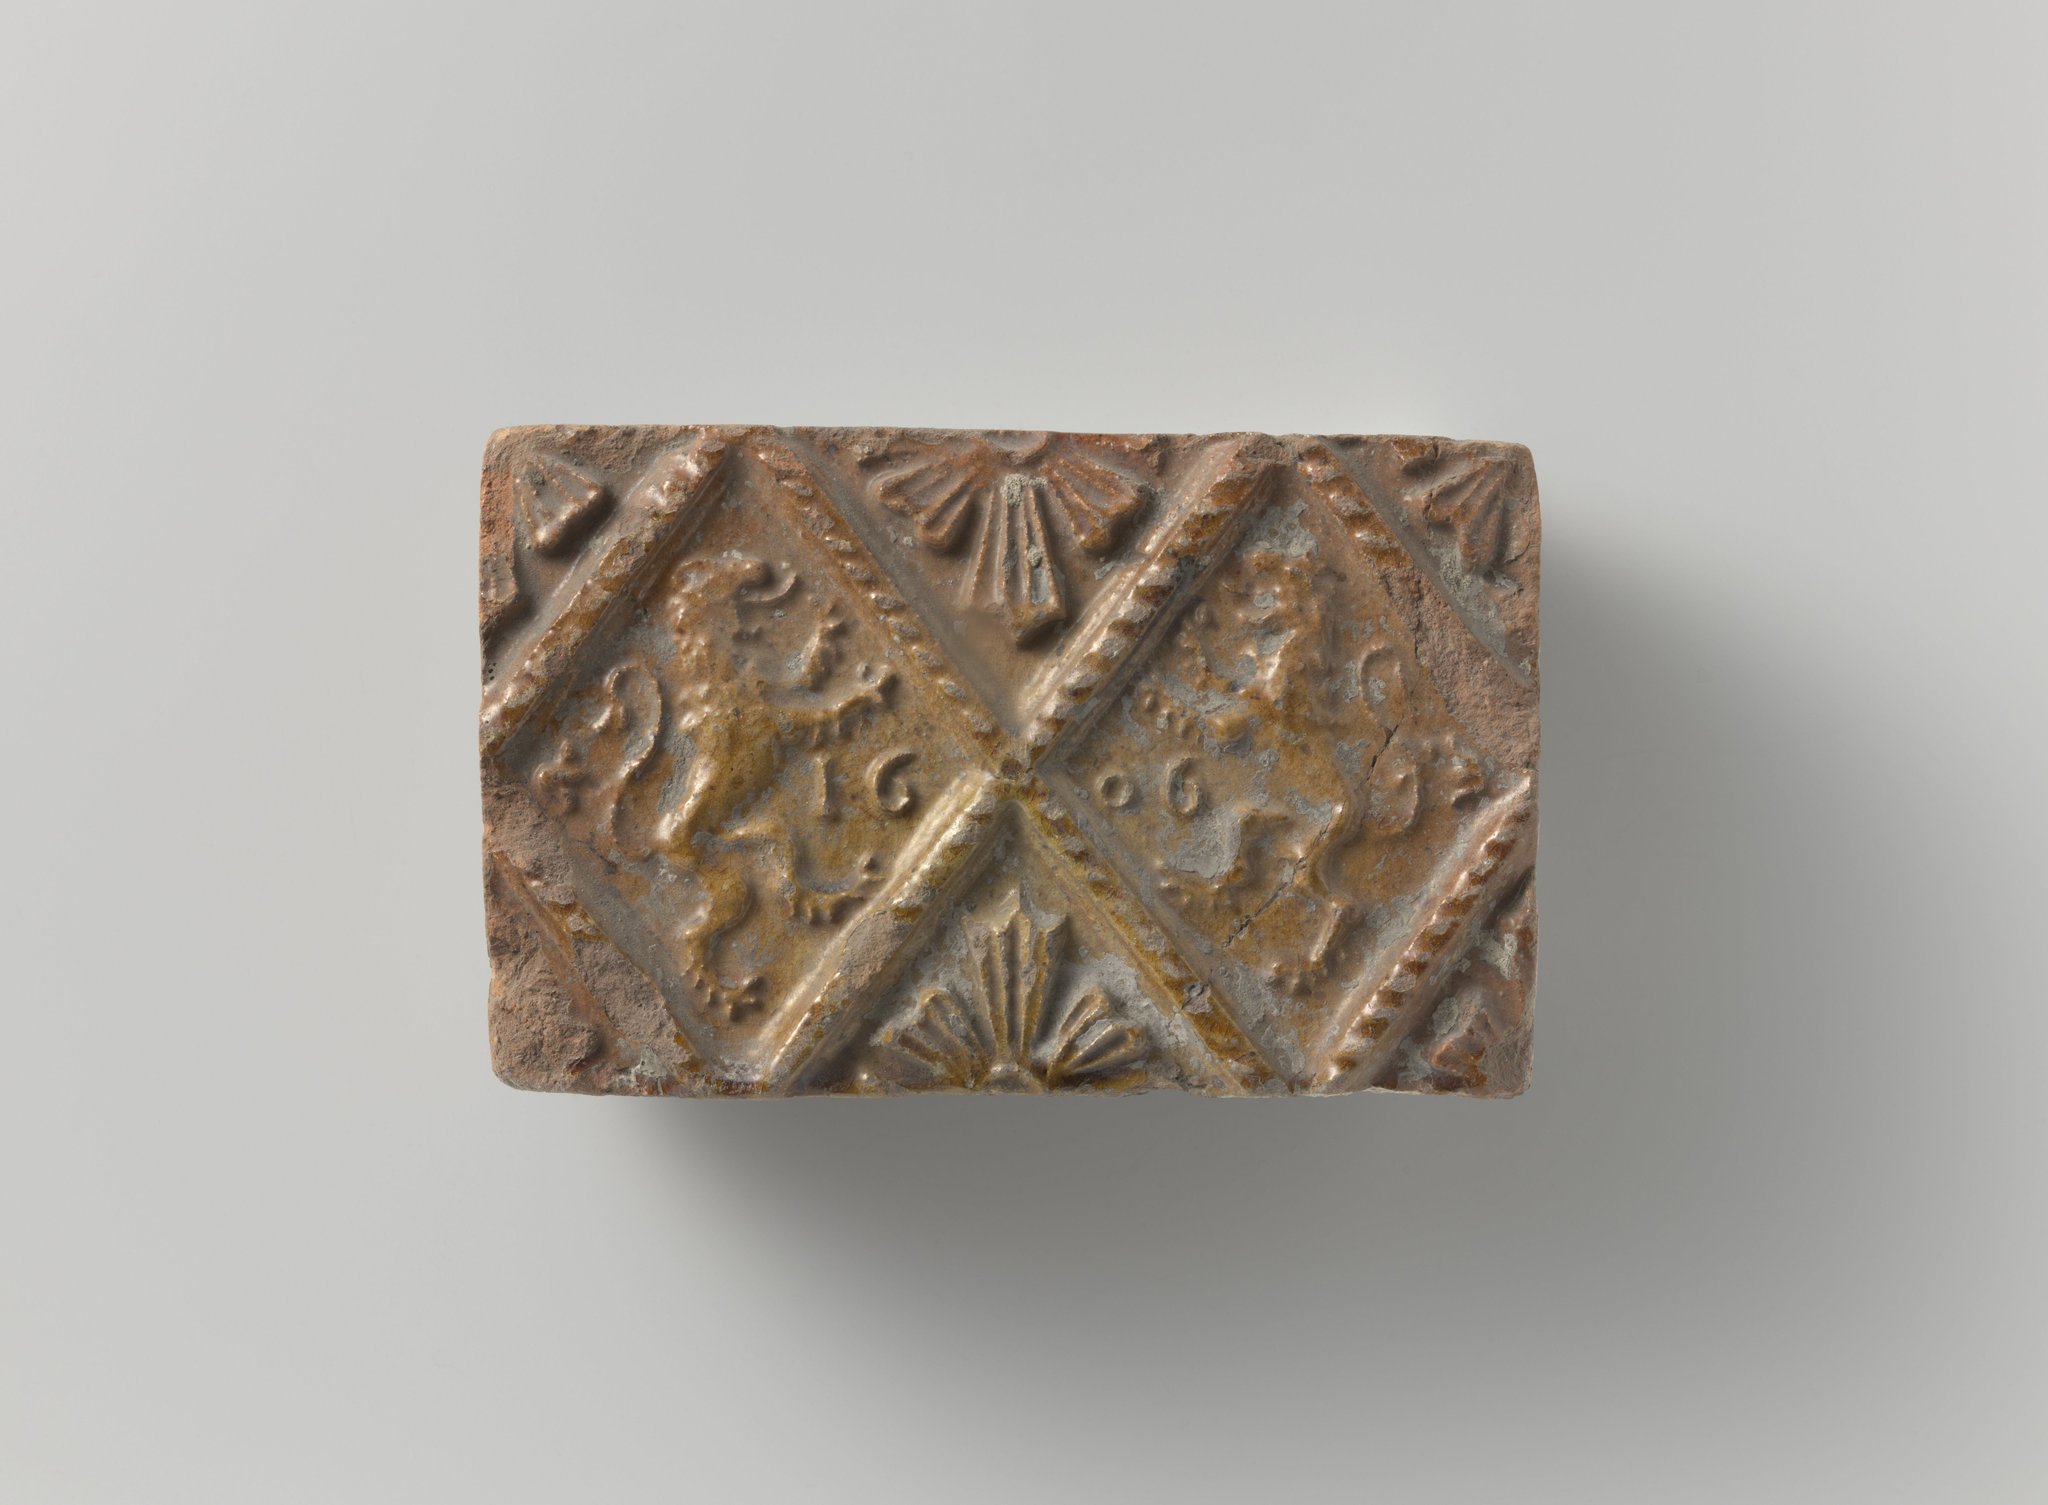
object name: architectural element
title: Verglaasde haardsteen met jaartal.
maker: Anonymous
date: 1606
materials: earthenware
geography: southern netherlands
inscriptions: date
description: Verglaasde haardsteen met het jaartal 1606. Bij de steen hoort een steen met inv. nr. BK-NM-1649.